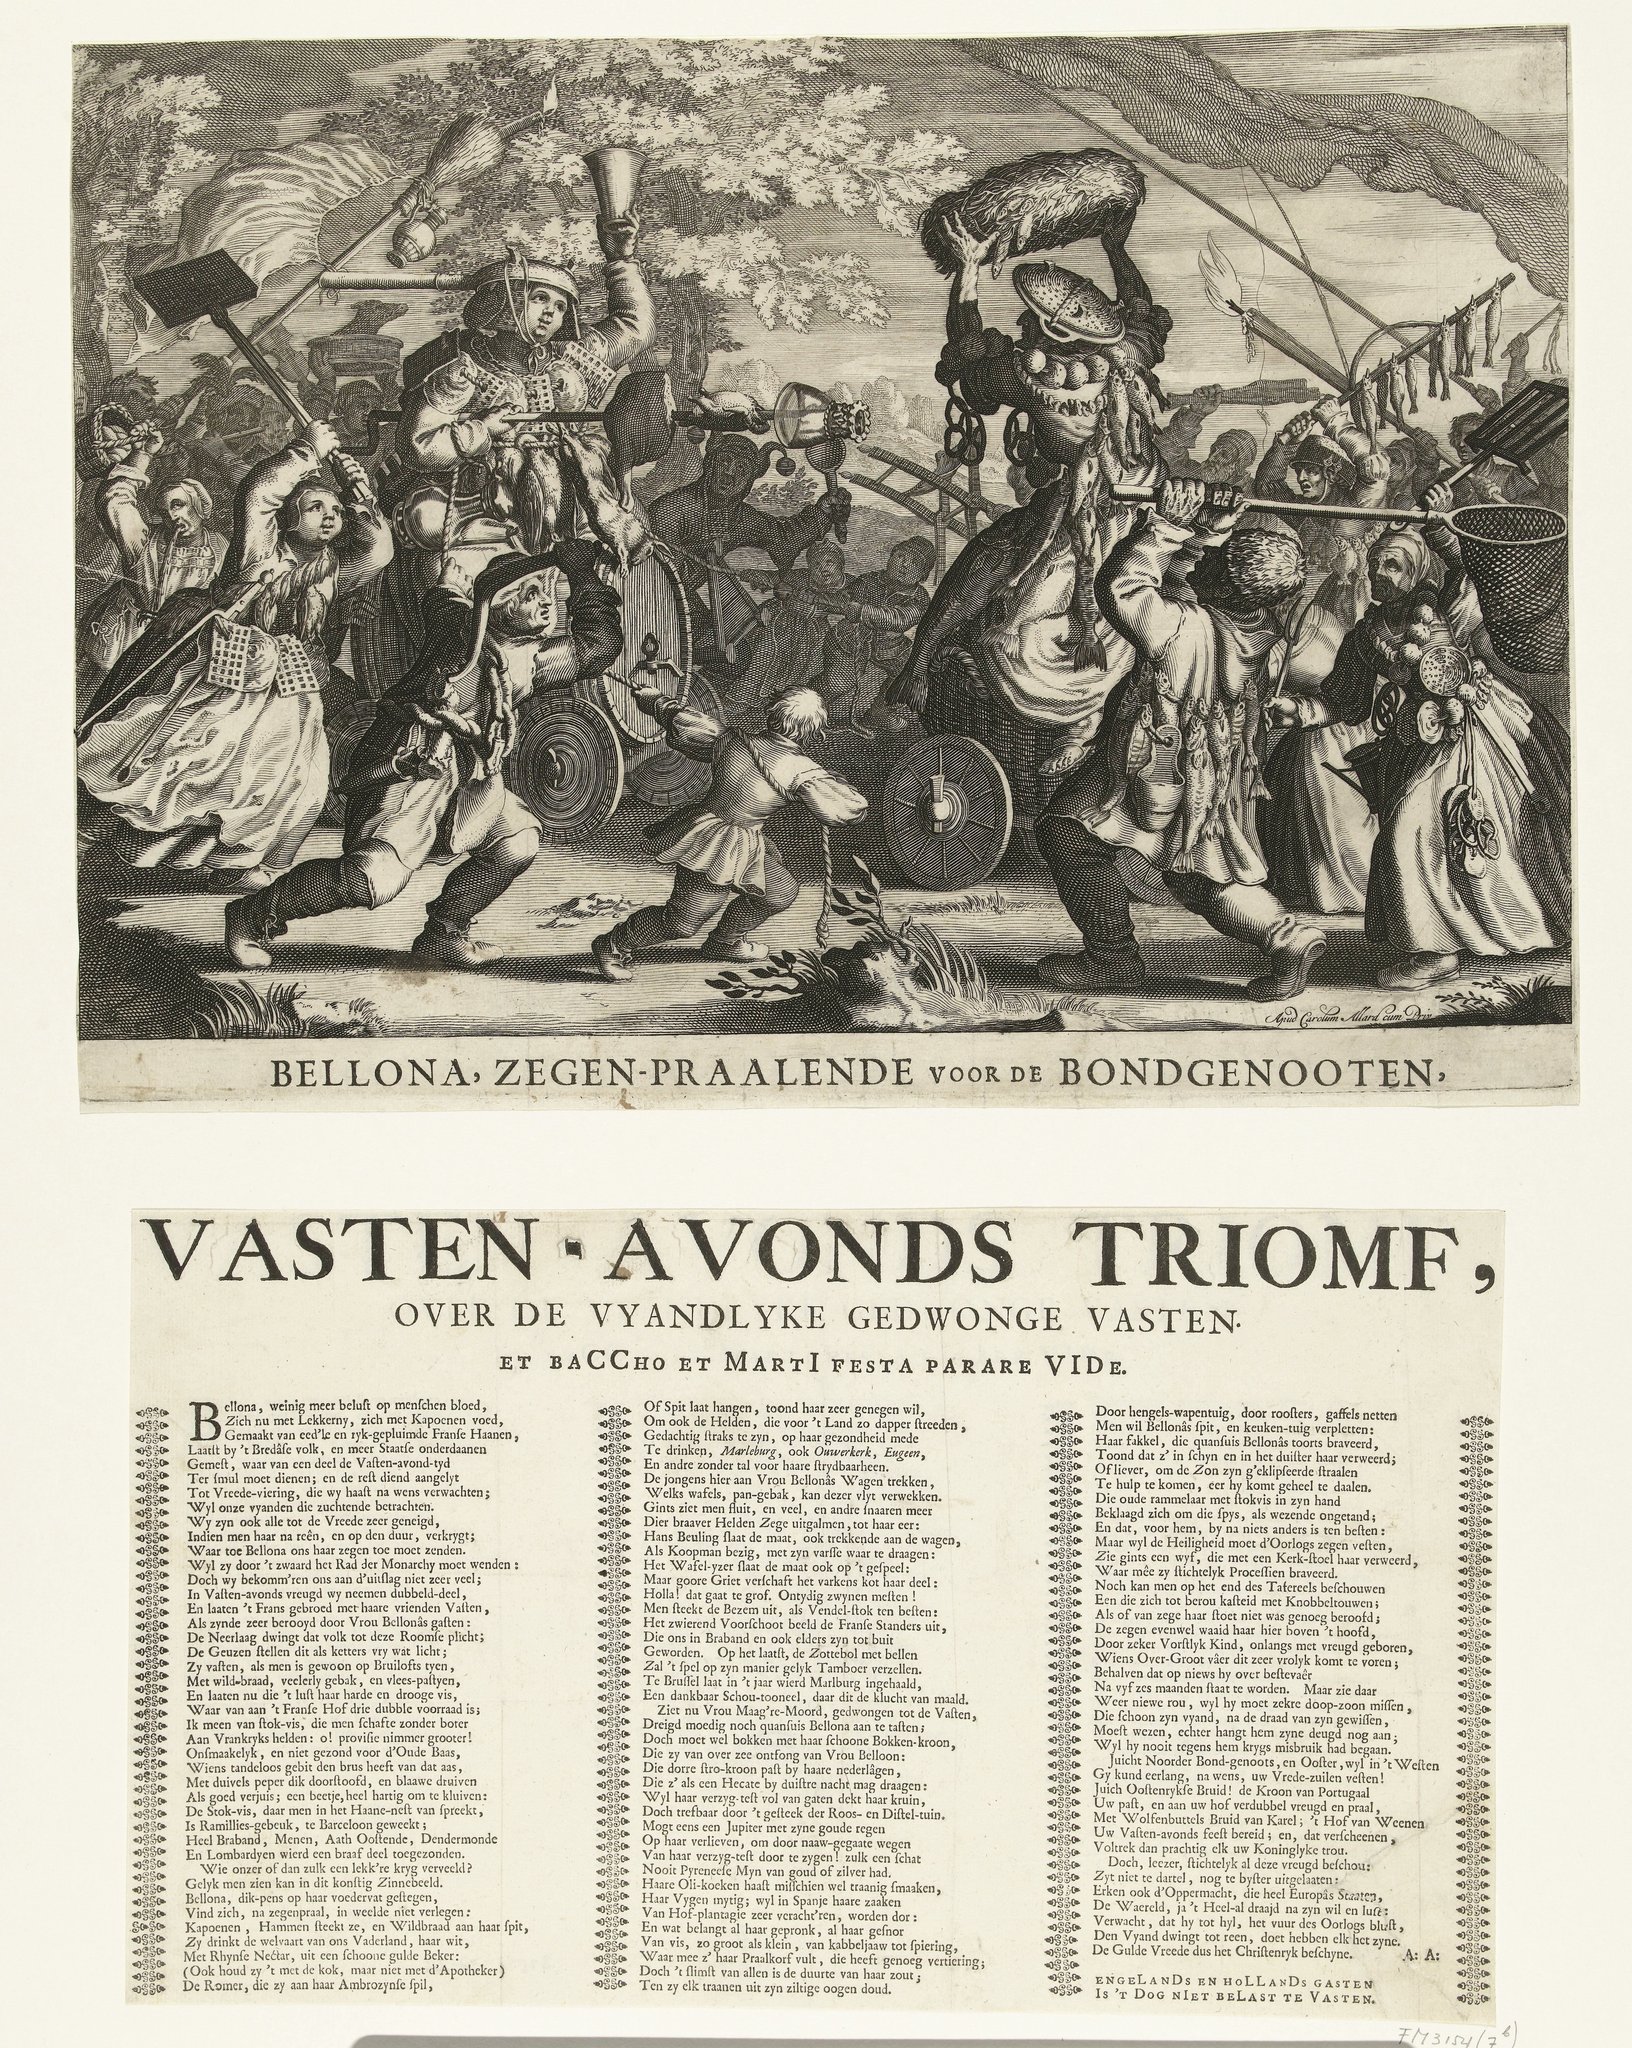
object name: cartoon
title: De strijd tussen Vastenavond en Vasten in de context van de Spaanse Successieoorlog, 1707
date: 1600-1633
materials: paper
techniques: engraving, letterpress printing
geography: amsterdam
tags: strife of lent and carnival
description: Spotprent met de strijd tussen Vastenavond en Vasten geplaatst in de context van de Spaanse Successieoorlog, 1707. Strijd tussen twee personen op strijdwagens getrokken door kinderen. Links Vastenavond, aangekleed met keukeninstrumenten, wild en gevogelte, drinkglazen en kannen. Rechts Vasten, aangekleed met vissen en krakelingen. Bij de voorstelling is ook een tekstblad met een Nederlands vers in 3 kolommen. Spotprent op de situatie in het jaar 1707 in de Spaanse Successieoorlog. Onderdeel van een reeks van 7 spotprenten op de Fransen en bondgenoten uit het jaar 1707.